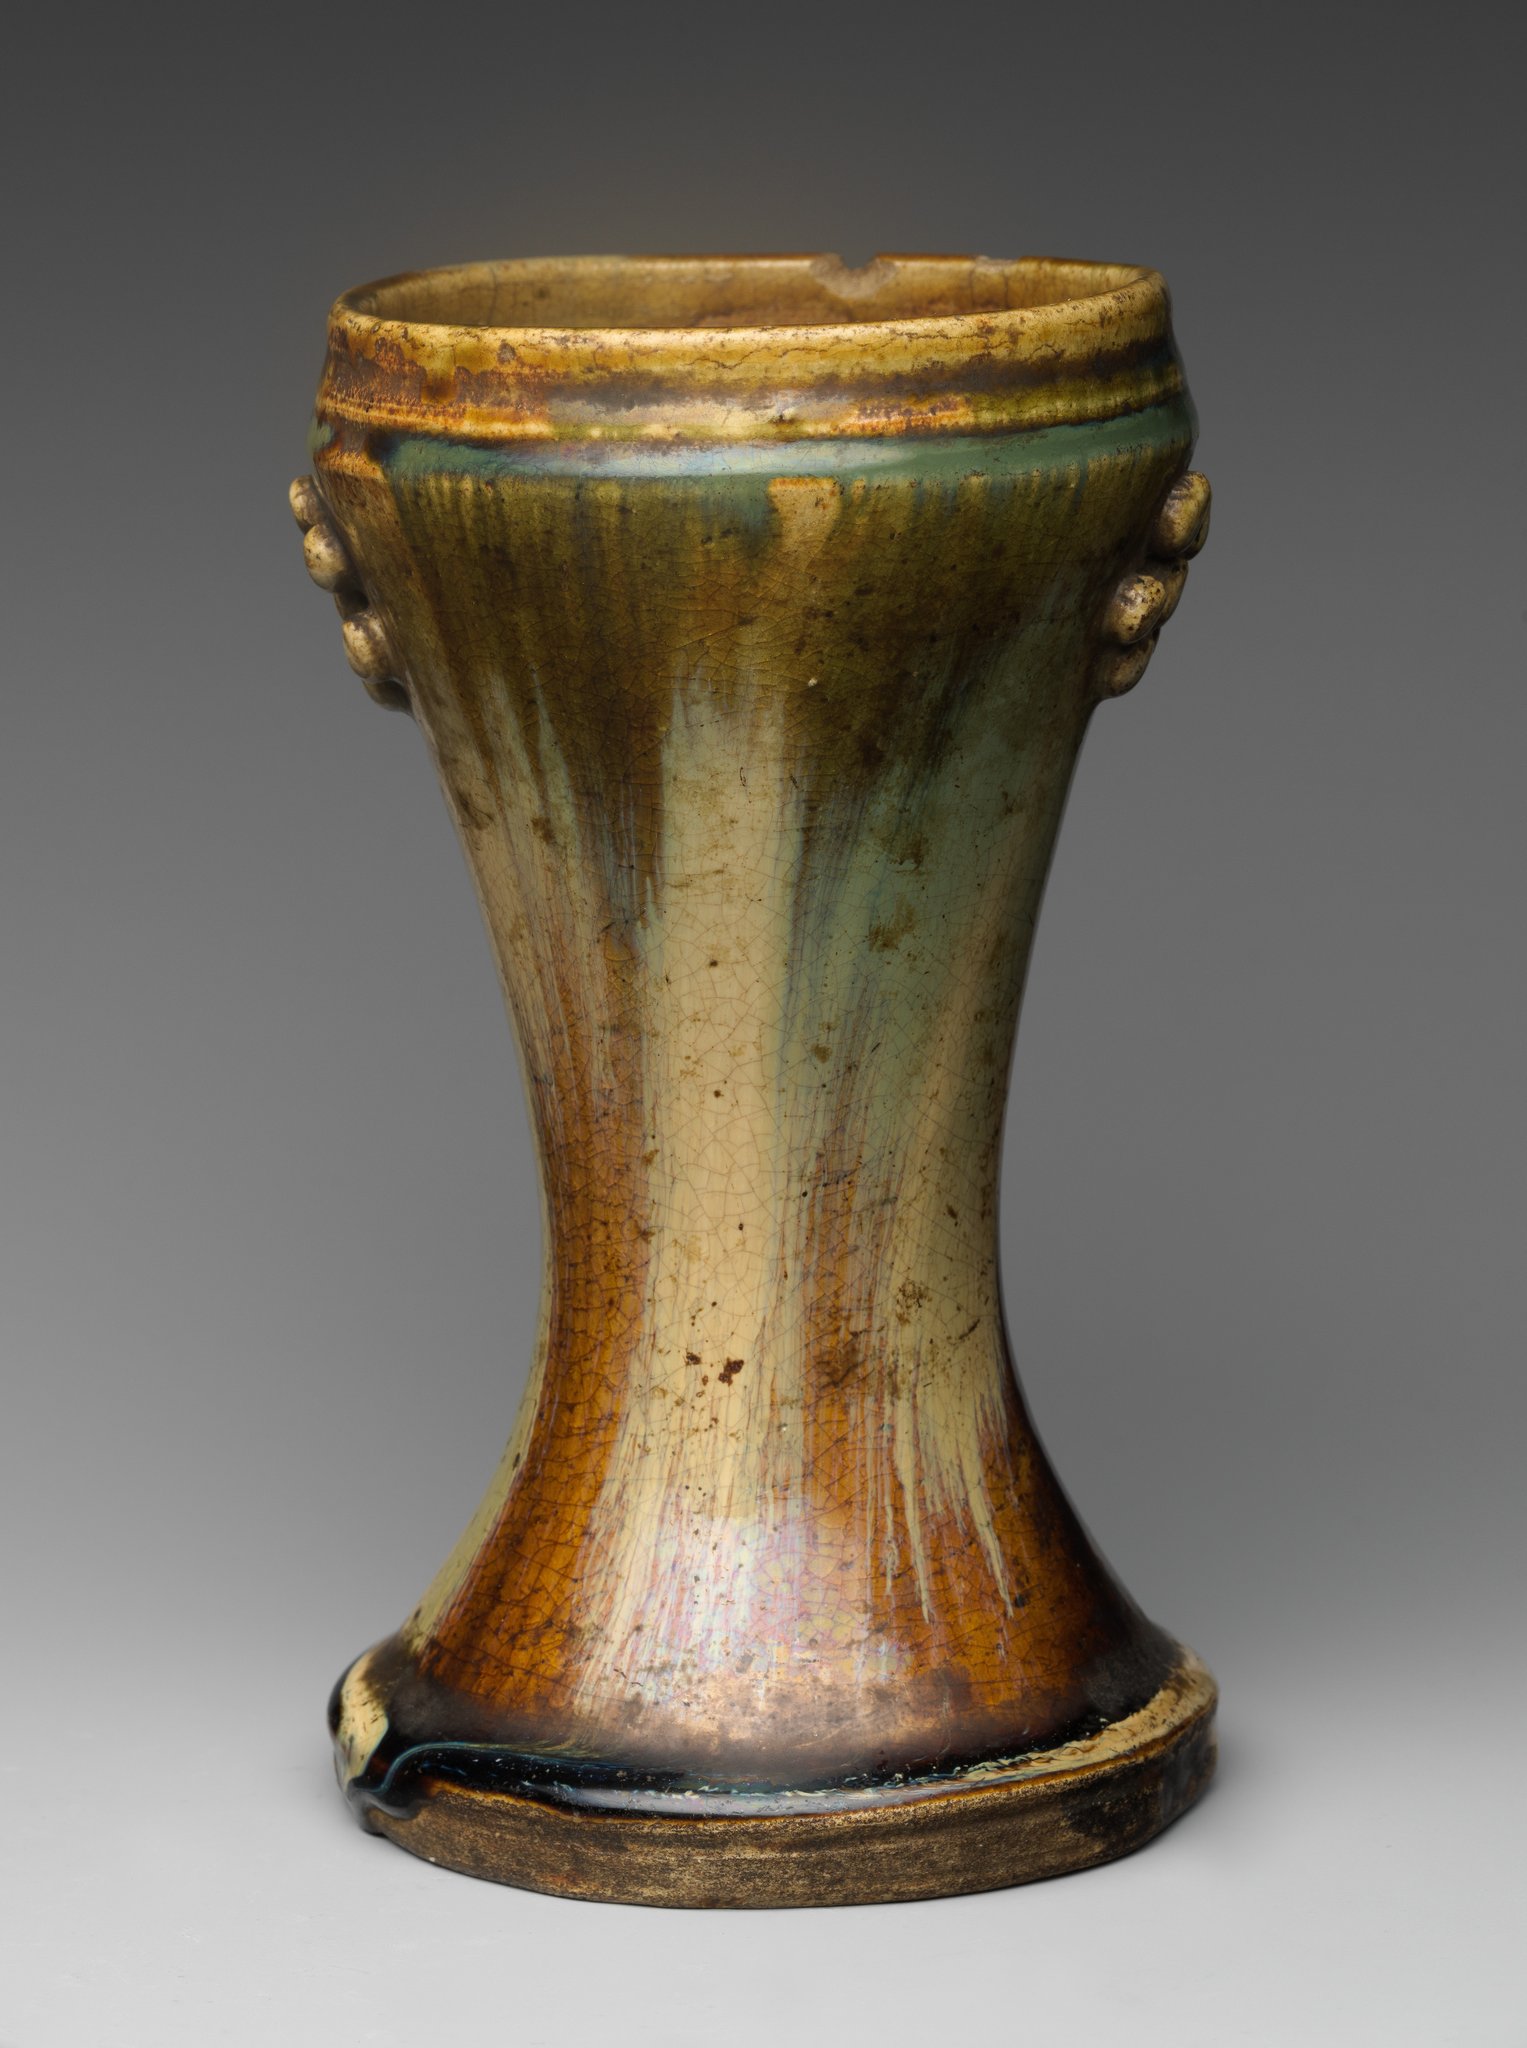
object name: vase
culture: japanese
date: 1701-1800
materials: clay, glaze